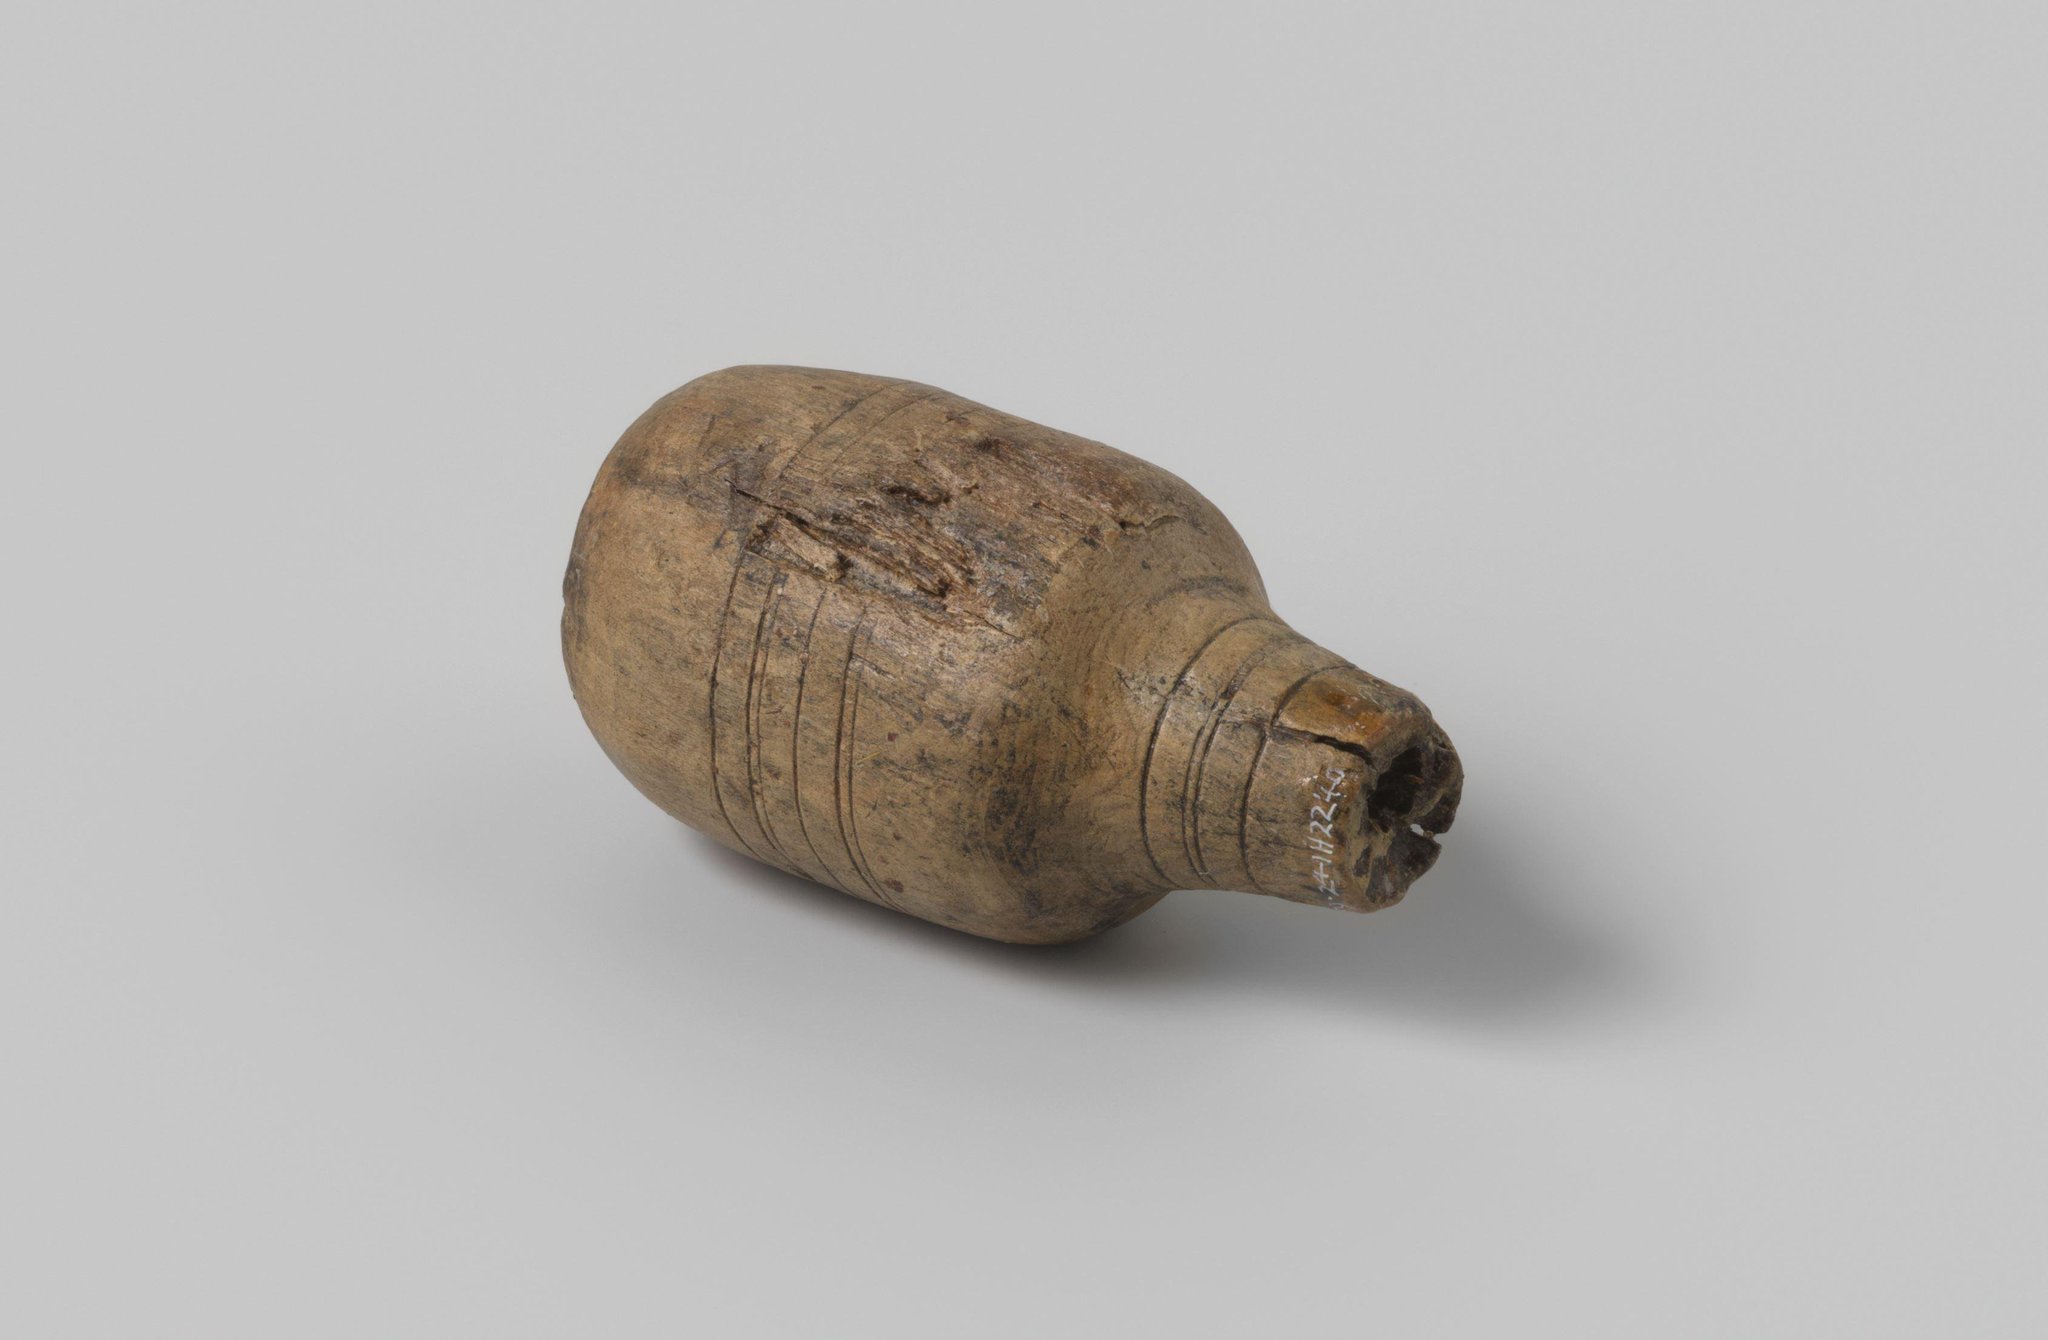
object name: chisel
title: Handvat van een priem of een beitel uit het wrak van de Oost-Indiëvaarder Hollandia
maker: Anonymous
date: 1700-1743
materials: wood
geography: netherlands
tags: verenigde oostindische compagnie, hollandia (schip), annet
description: Tools and instruments, various tools, awl/chisel handle; bulbous, flat upper end, straight sides, lower end tapering, broken off, linear concentric engravings.